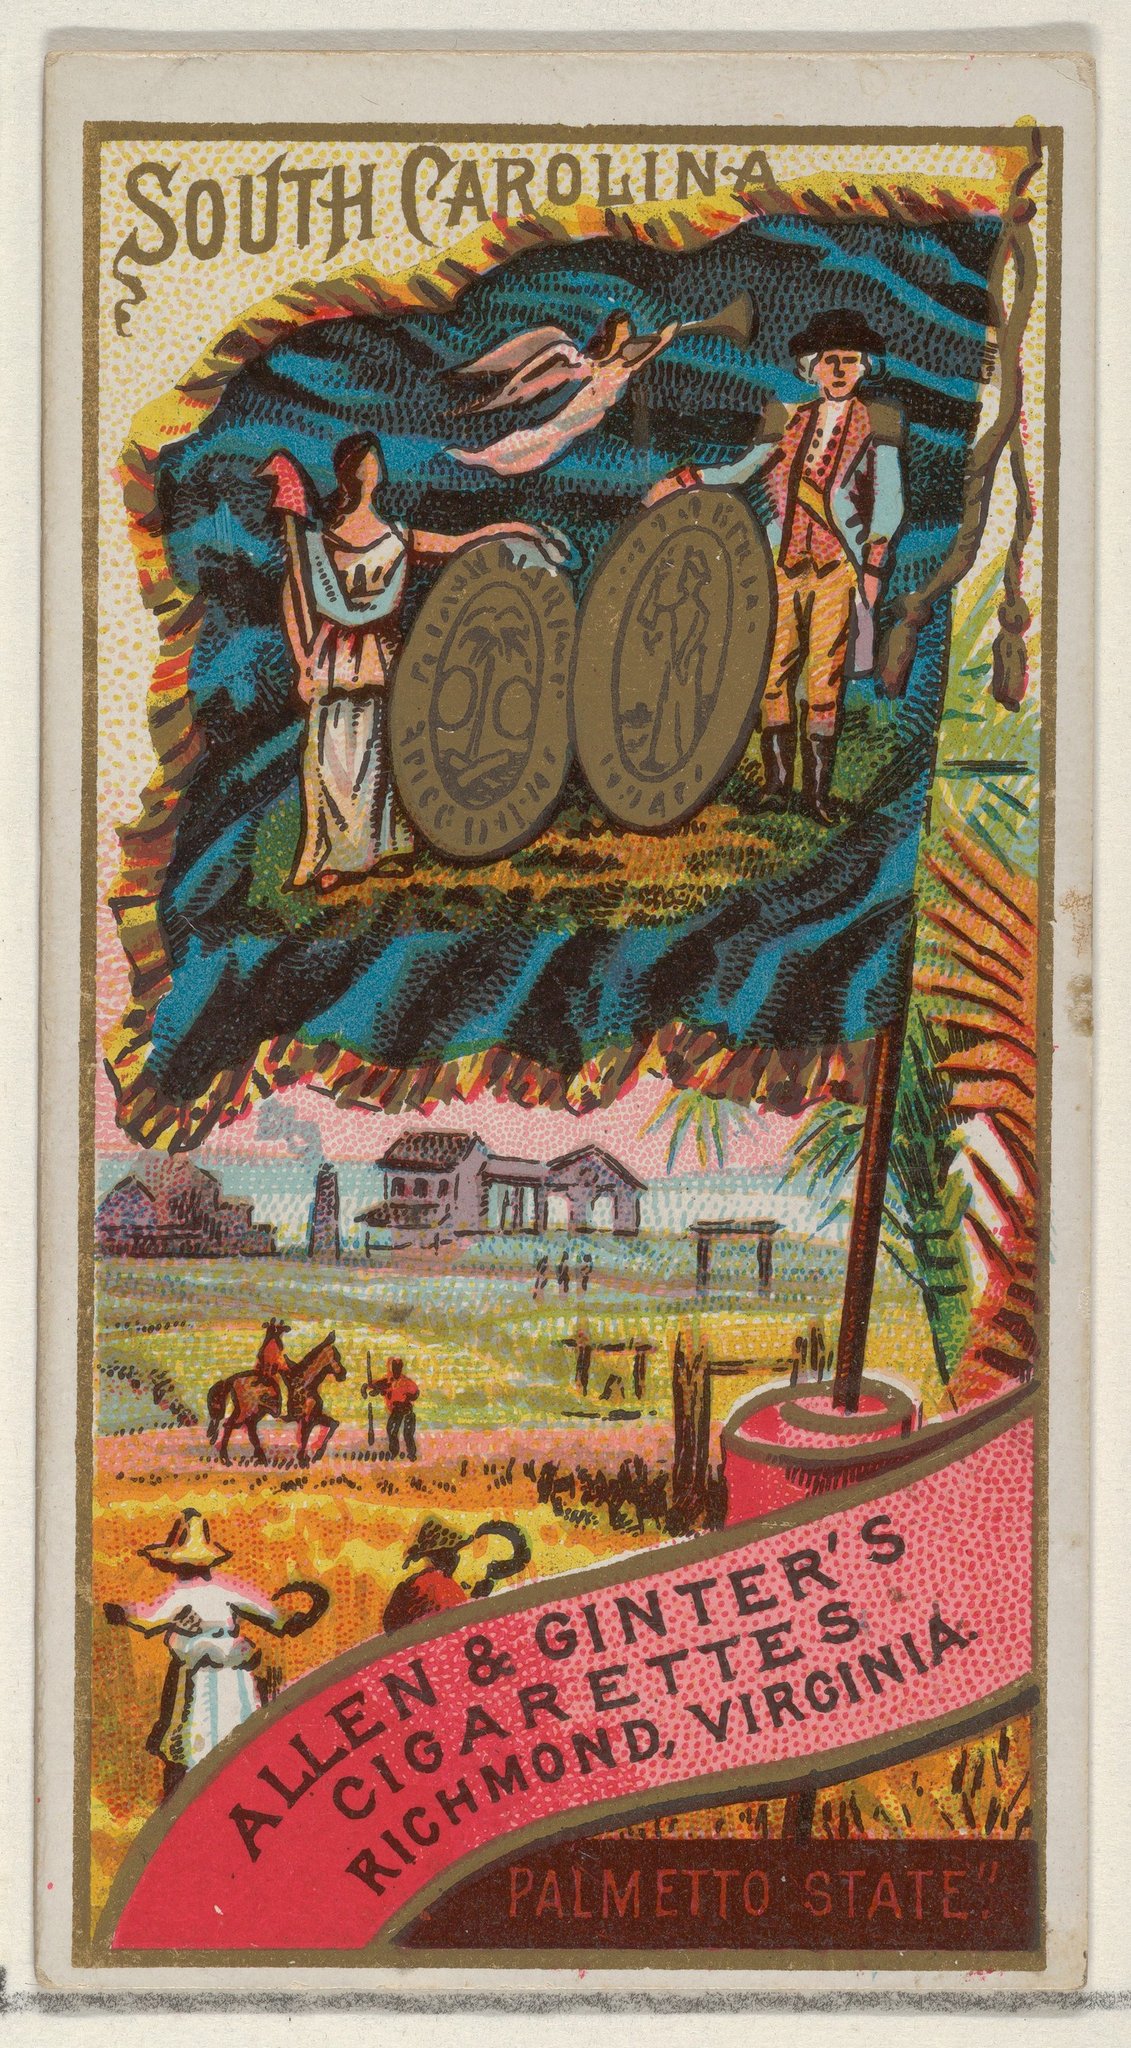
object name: print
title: South Carolina, from Flags of the States and Territories (N11) for Allen & Ginter Cigarettes Brands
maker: allen & ginter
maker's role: publisher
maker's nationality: american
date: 1888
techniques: color lithograph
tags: flags